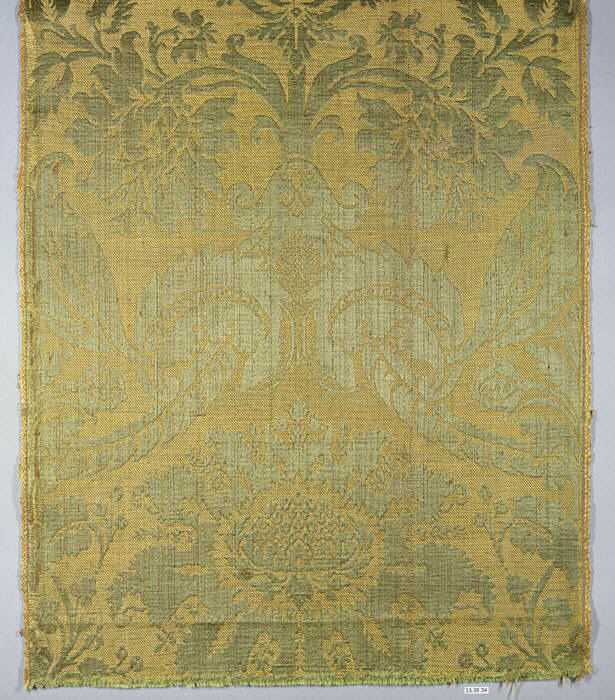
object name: piece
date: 1710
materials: hemp, silk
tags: flowers